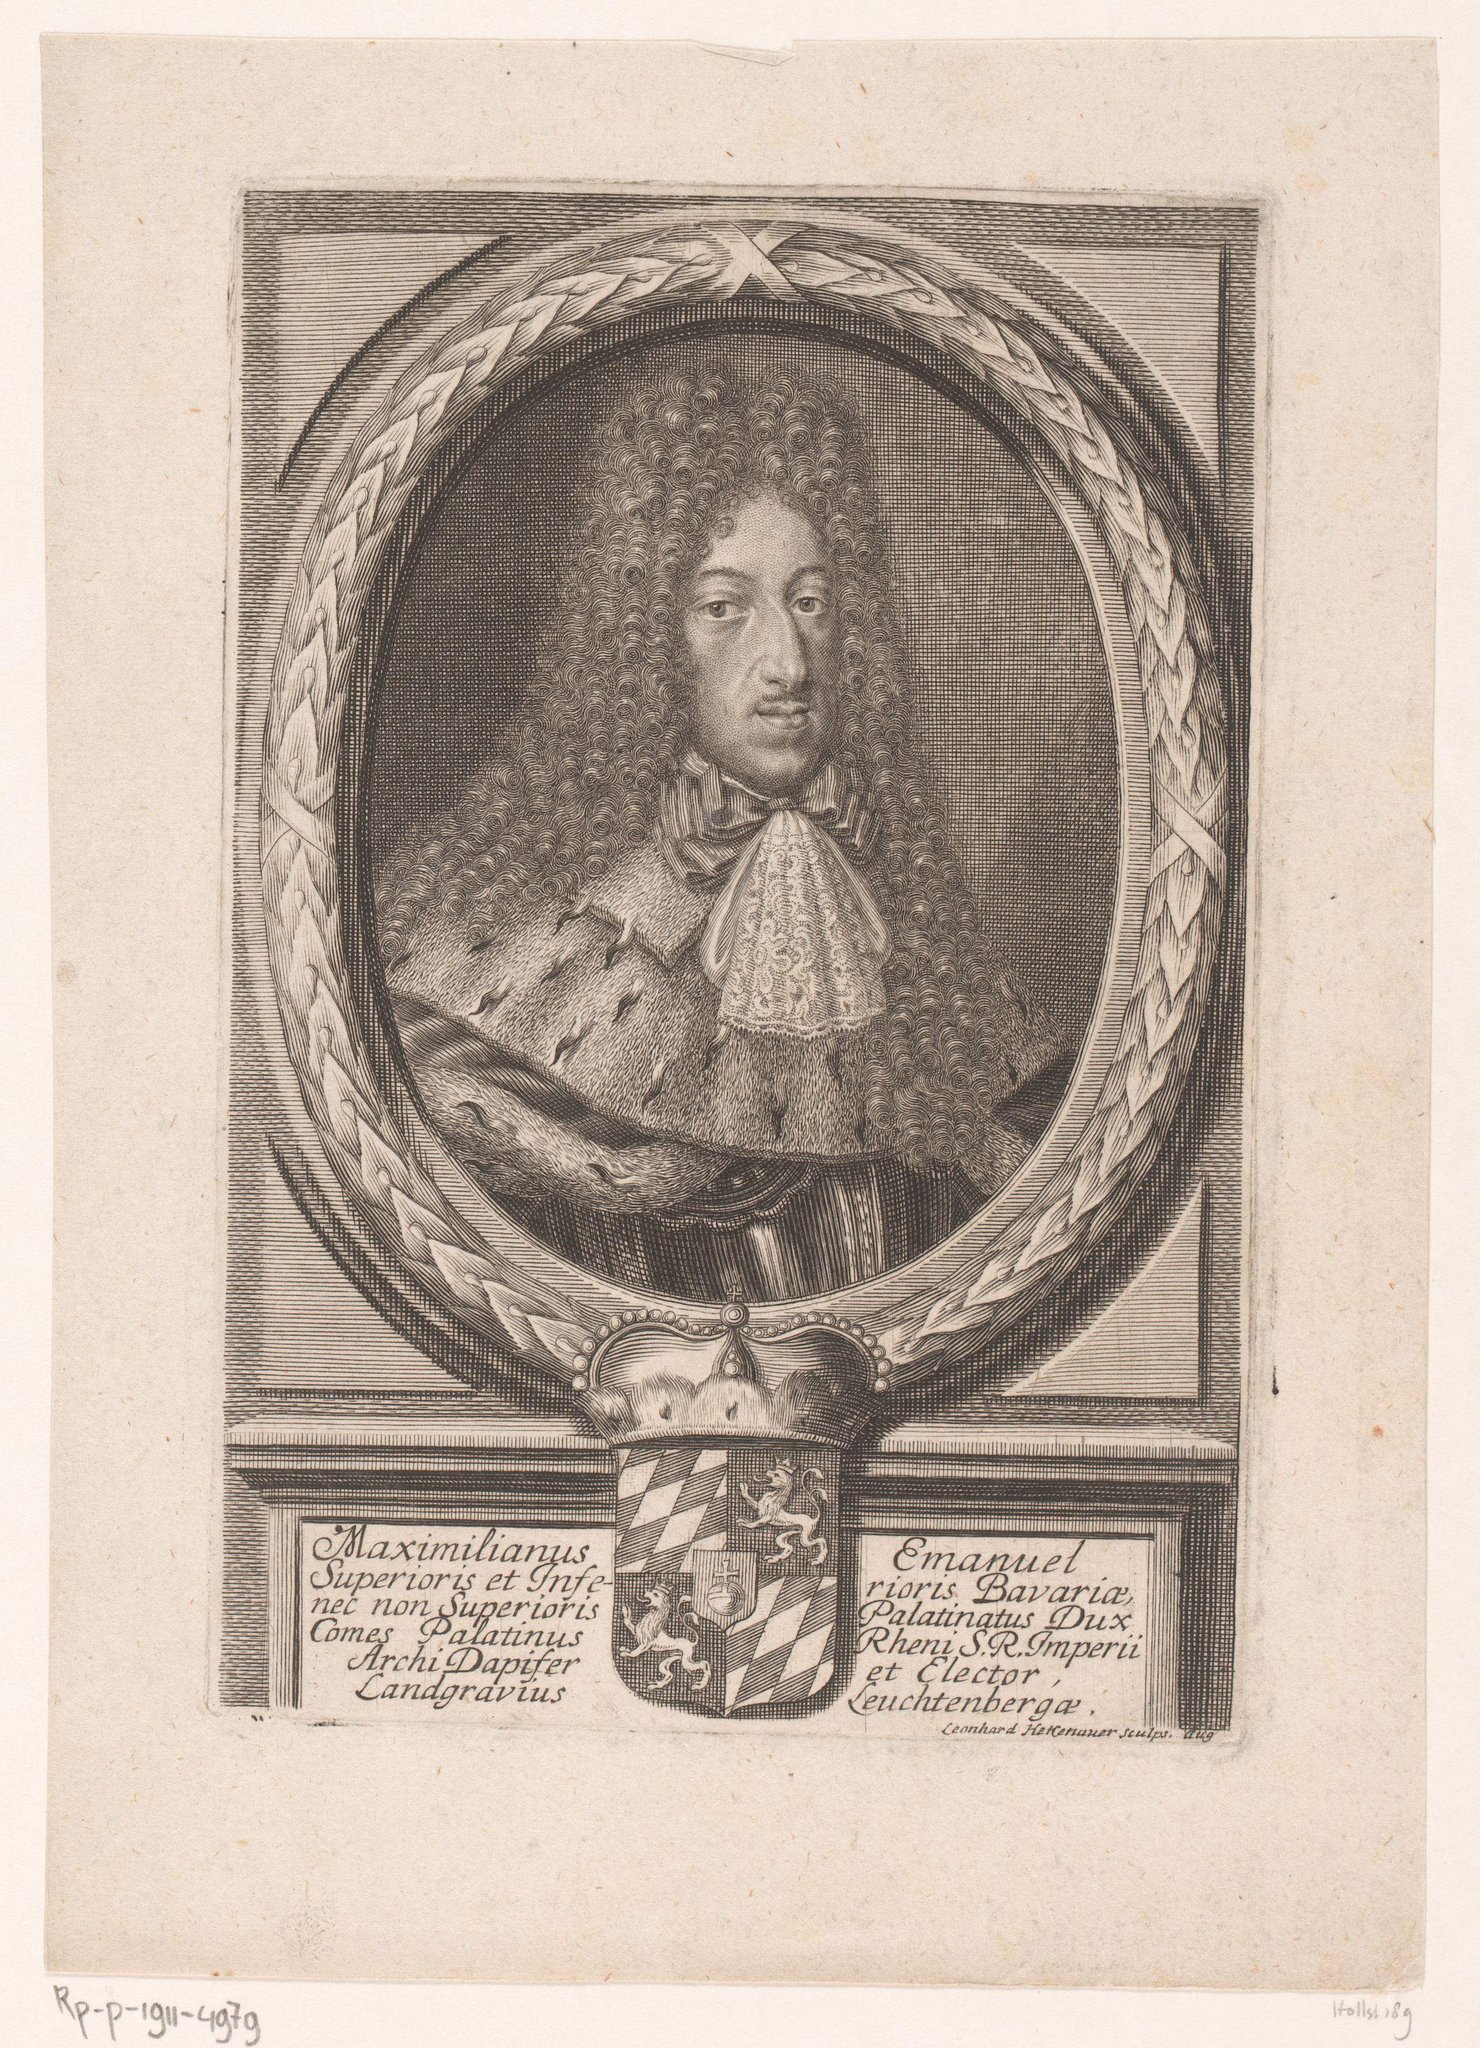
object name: print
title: Portret van Maximiliaan II Emanuel van Beieren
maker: leonhard heckenauer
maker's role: print maker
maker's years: 1650-1704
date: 1690-1697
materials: paper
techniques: engraving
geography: augsburg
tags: maximiliaan ii emanuel (keurvorst van beieren), trees: laurel (branch, stick), historical persons, ruler, sovereign, armorial bearing, heraldry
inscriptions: collector's mark: Lugt 2228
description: Prent gebruikt voor: Thucelius, Christian Leonhard. Austria S.R.Imperio Conjux (...). Augsburg: Lorenz Kroniger, [1690]. Of prent gebruikt voor: Thulemarius, Heinrich Günther. Tractatio de Bulla aurea, argentea, plumbea et cerea in genere, nec non in specie de Aurea Bulla Caroli IV Imperatoris (...). Frankfurt am Main: Johann Melchior Bencard, 1697.